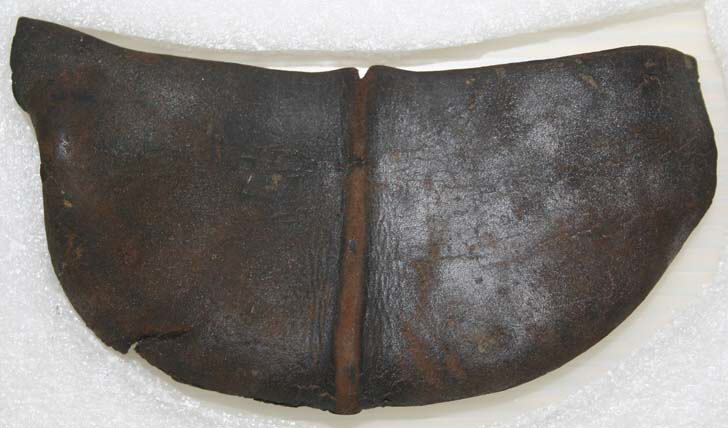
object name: shoe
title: Shoes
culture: british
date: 1501-1600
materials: leather